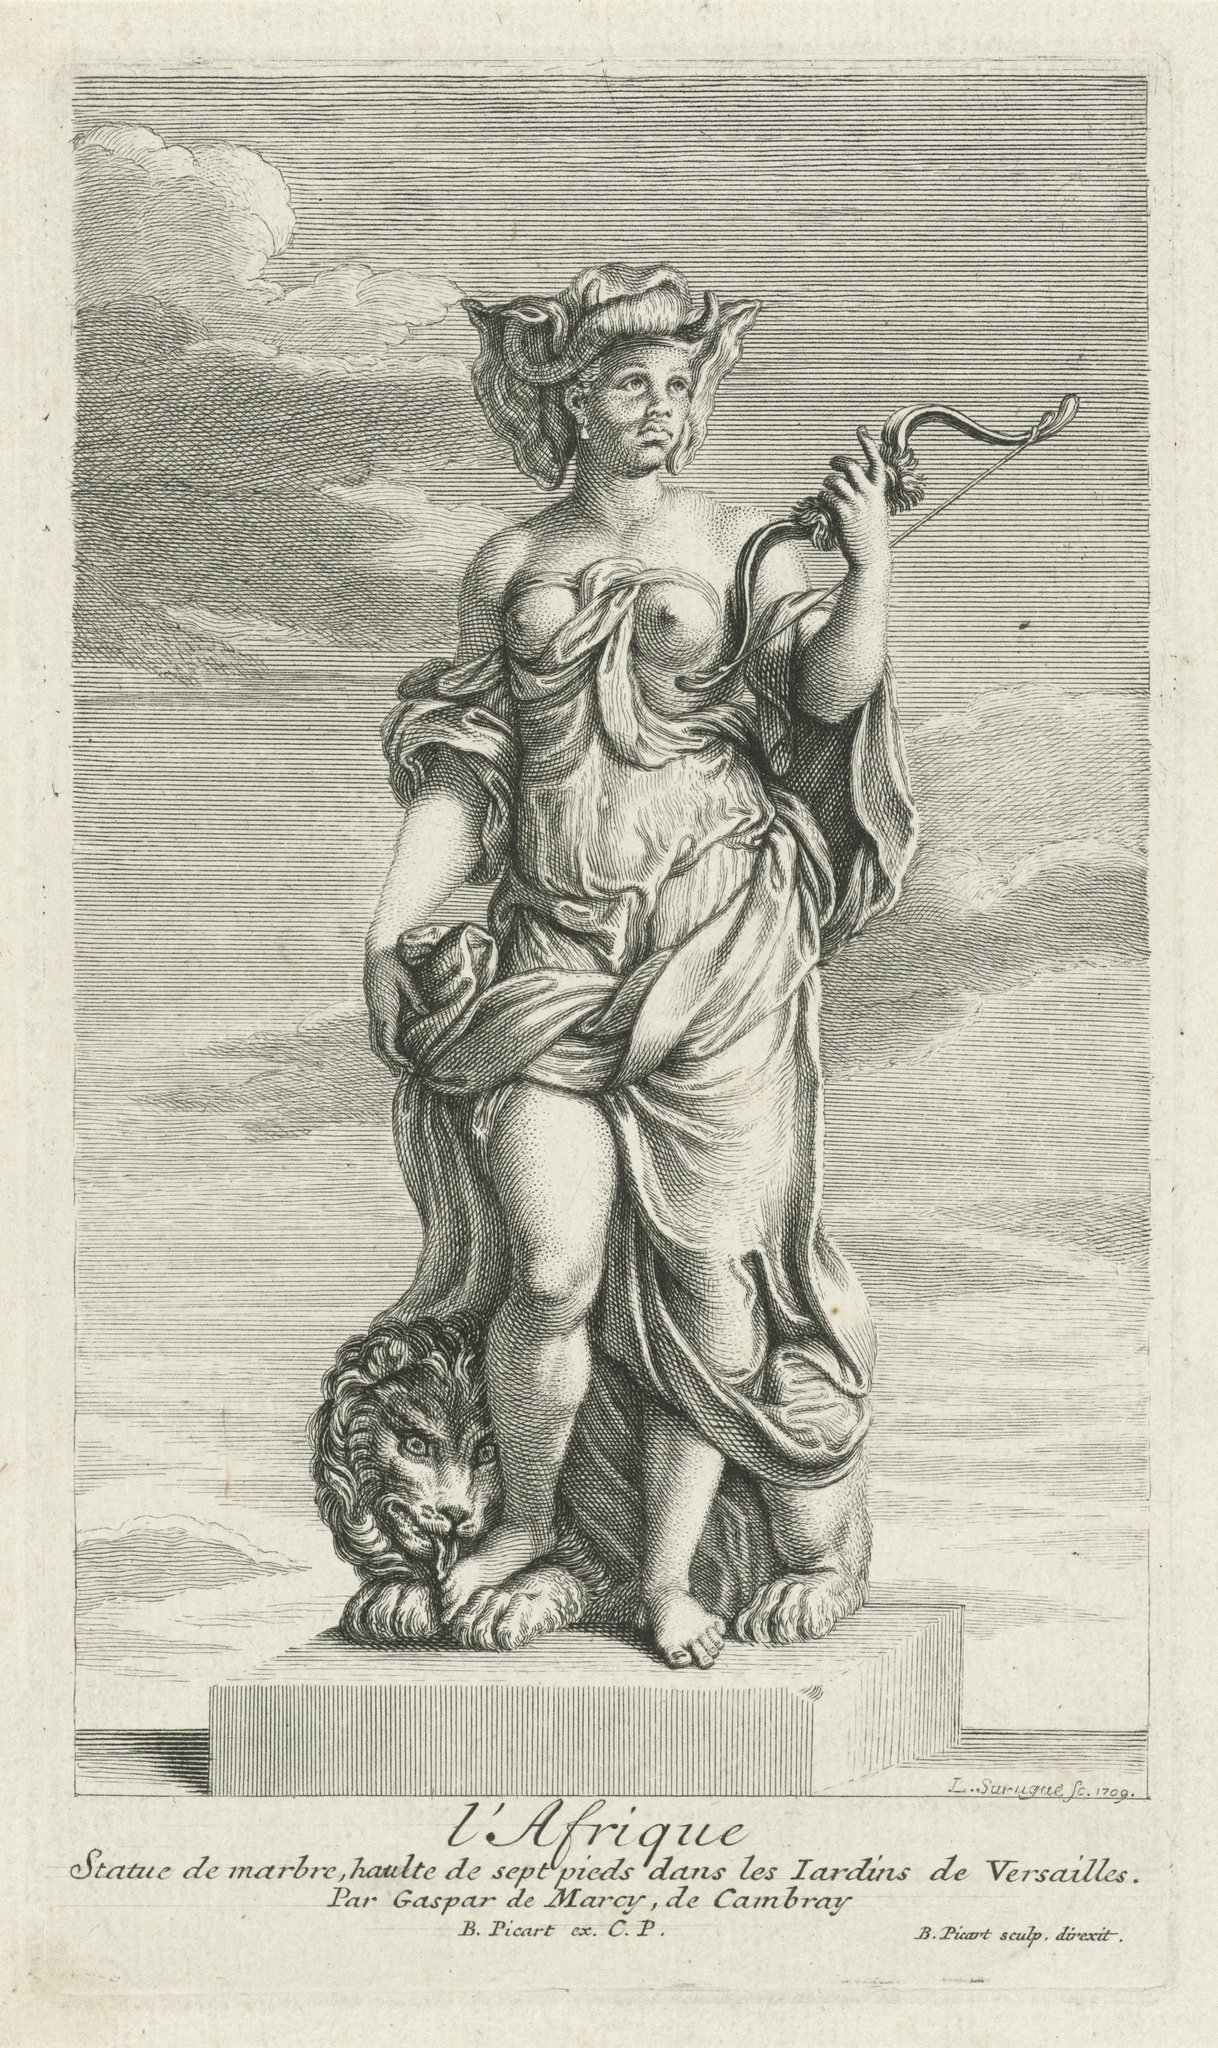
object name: print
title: Afrika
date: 1709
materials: paper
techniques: engraving, etching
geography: paris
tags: africa represented allegorically; 'africa' (ripa), piece of sculpture, reproduction of a piece of sculpture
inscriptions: collector's mark: Lugt 240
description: Standbeeld in de tuinen van Versailles. De vrouwelijke personificatie van Afrika, gekroond met koralen, een boog in de hand. Aan haar voeten een leeuw. In de marge een onderschrift in het Frans.